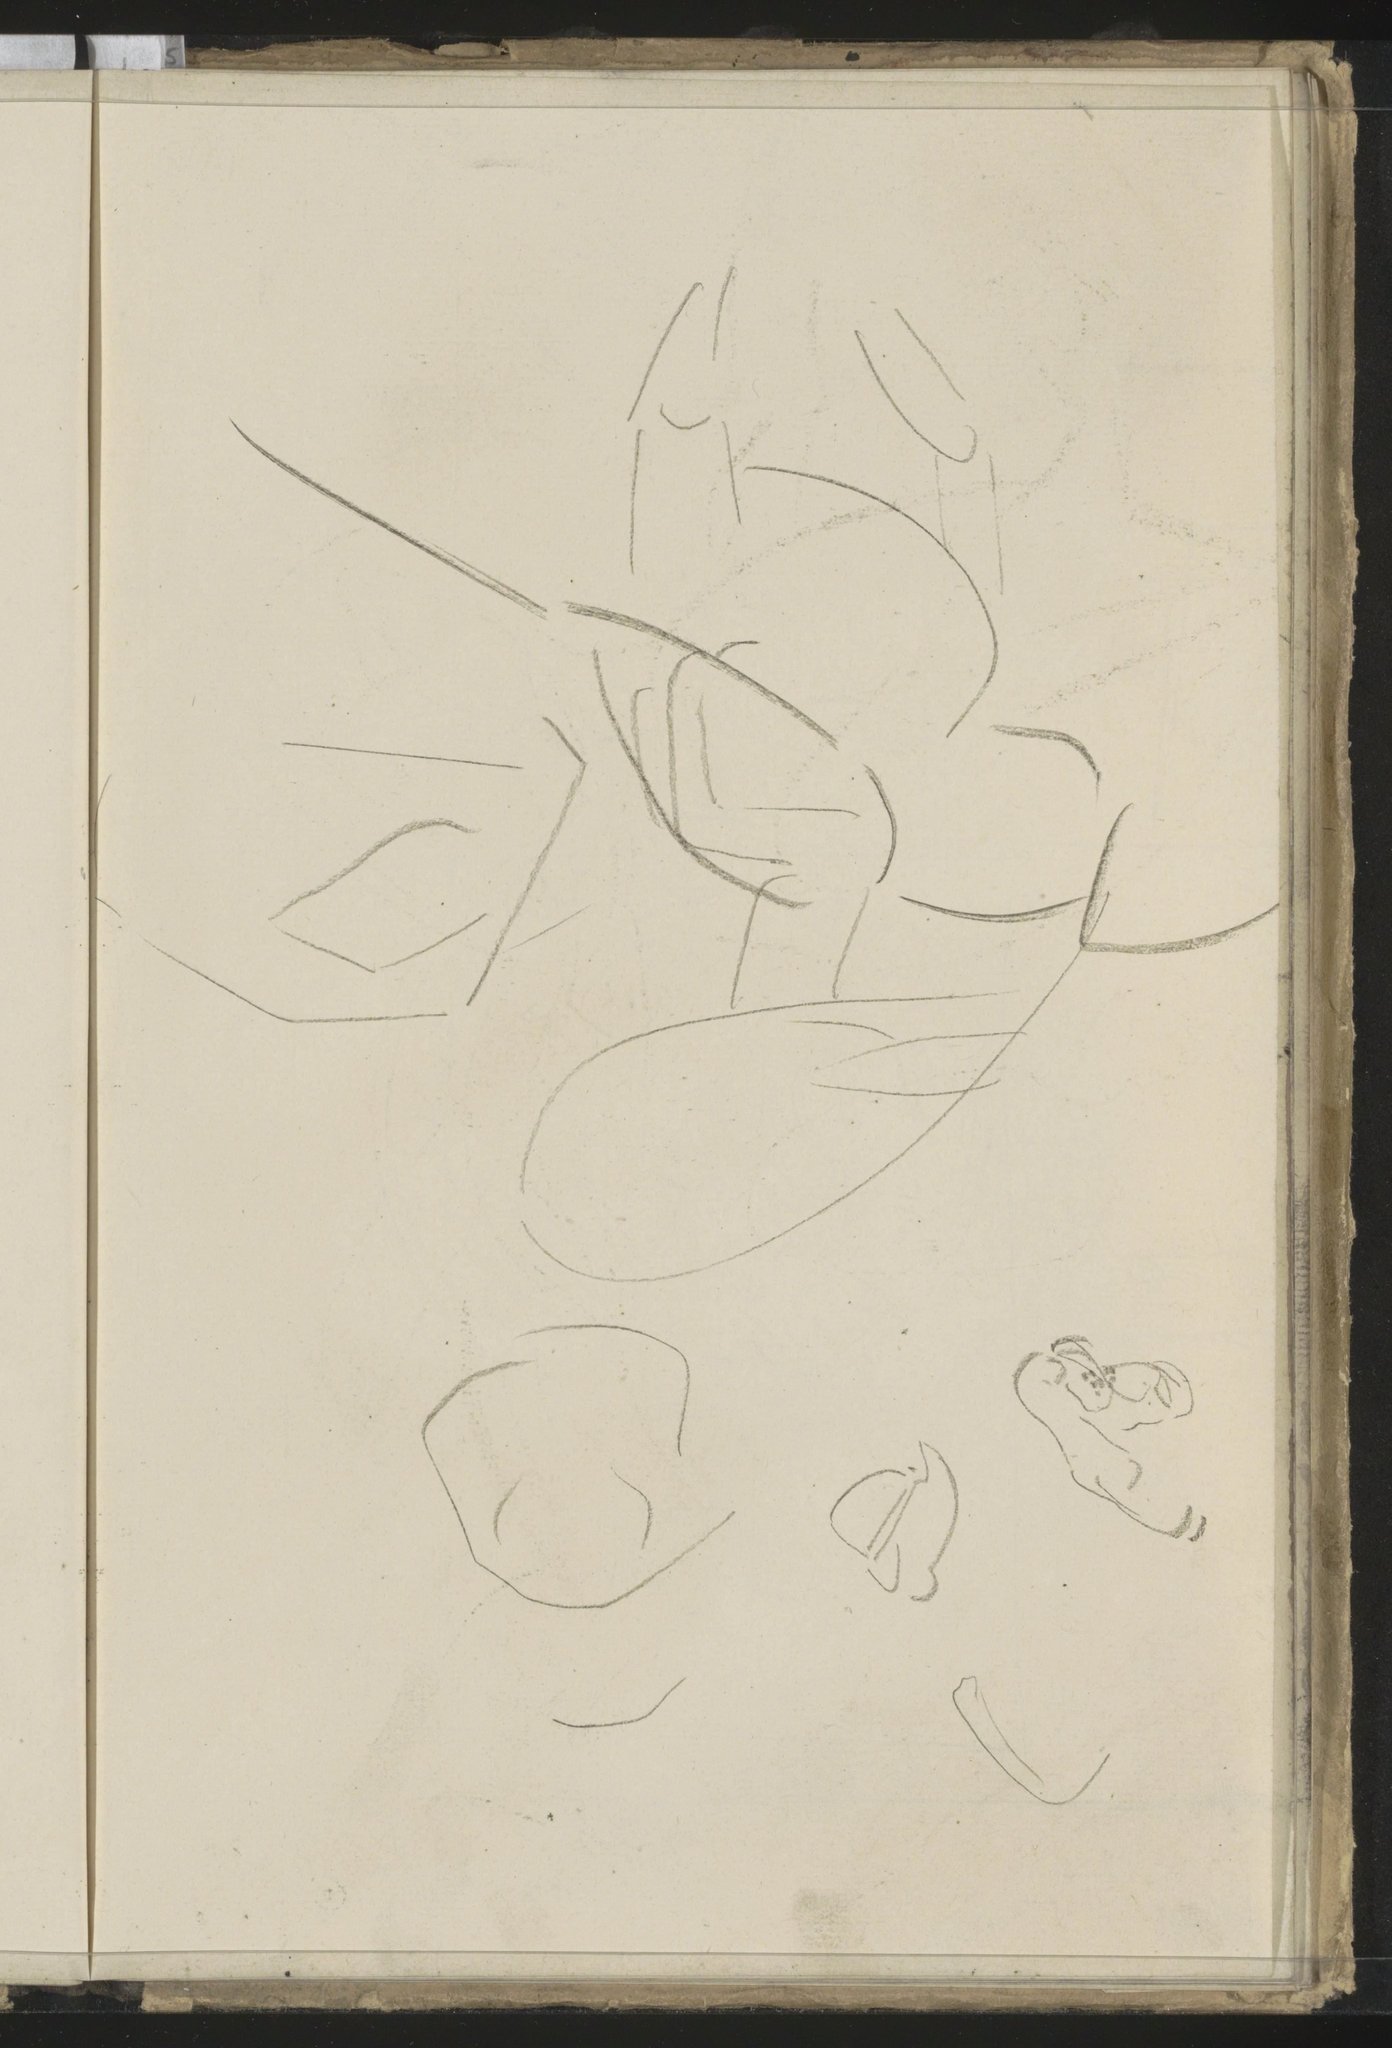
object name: sketchbook leaf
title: Papegaai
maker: carel adolph lion cachet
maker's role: draughtsman, print maker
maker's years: 1864-1945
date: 1890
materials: chalk, paper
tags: ornamental birds: parrot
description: Blad 24 recto uit een schetsboek met 38 bladen.